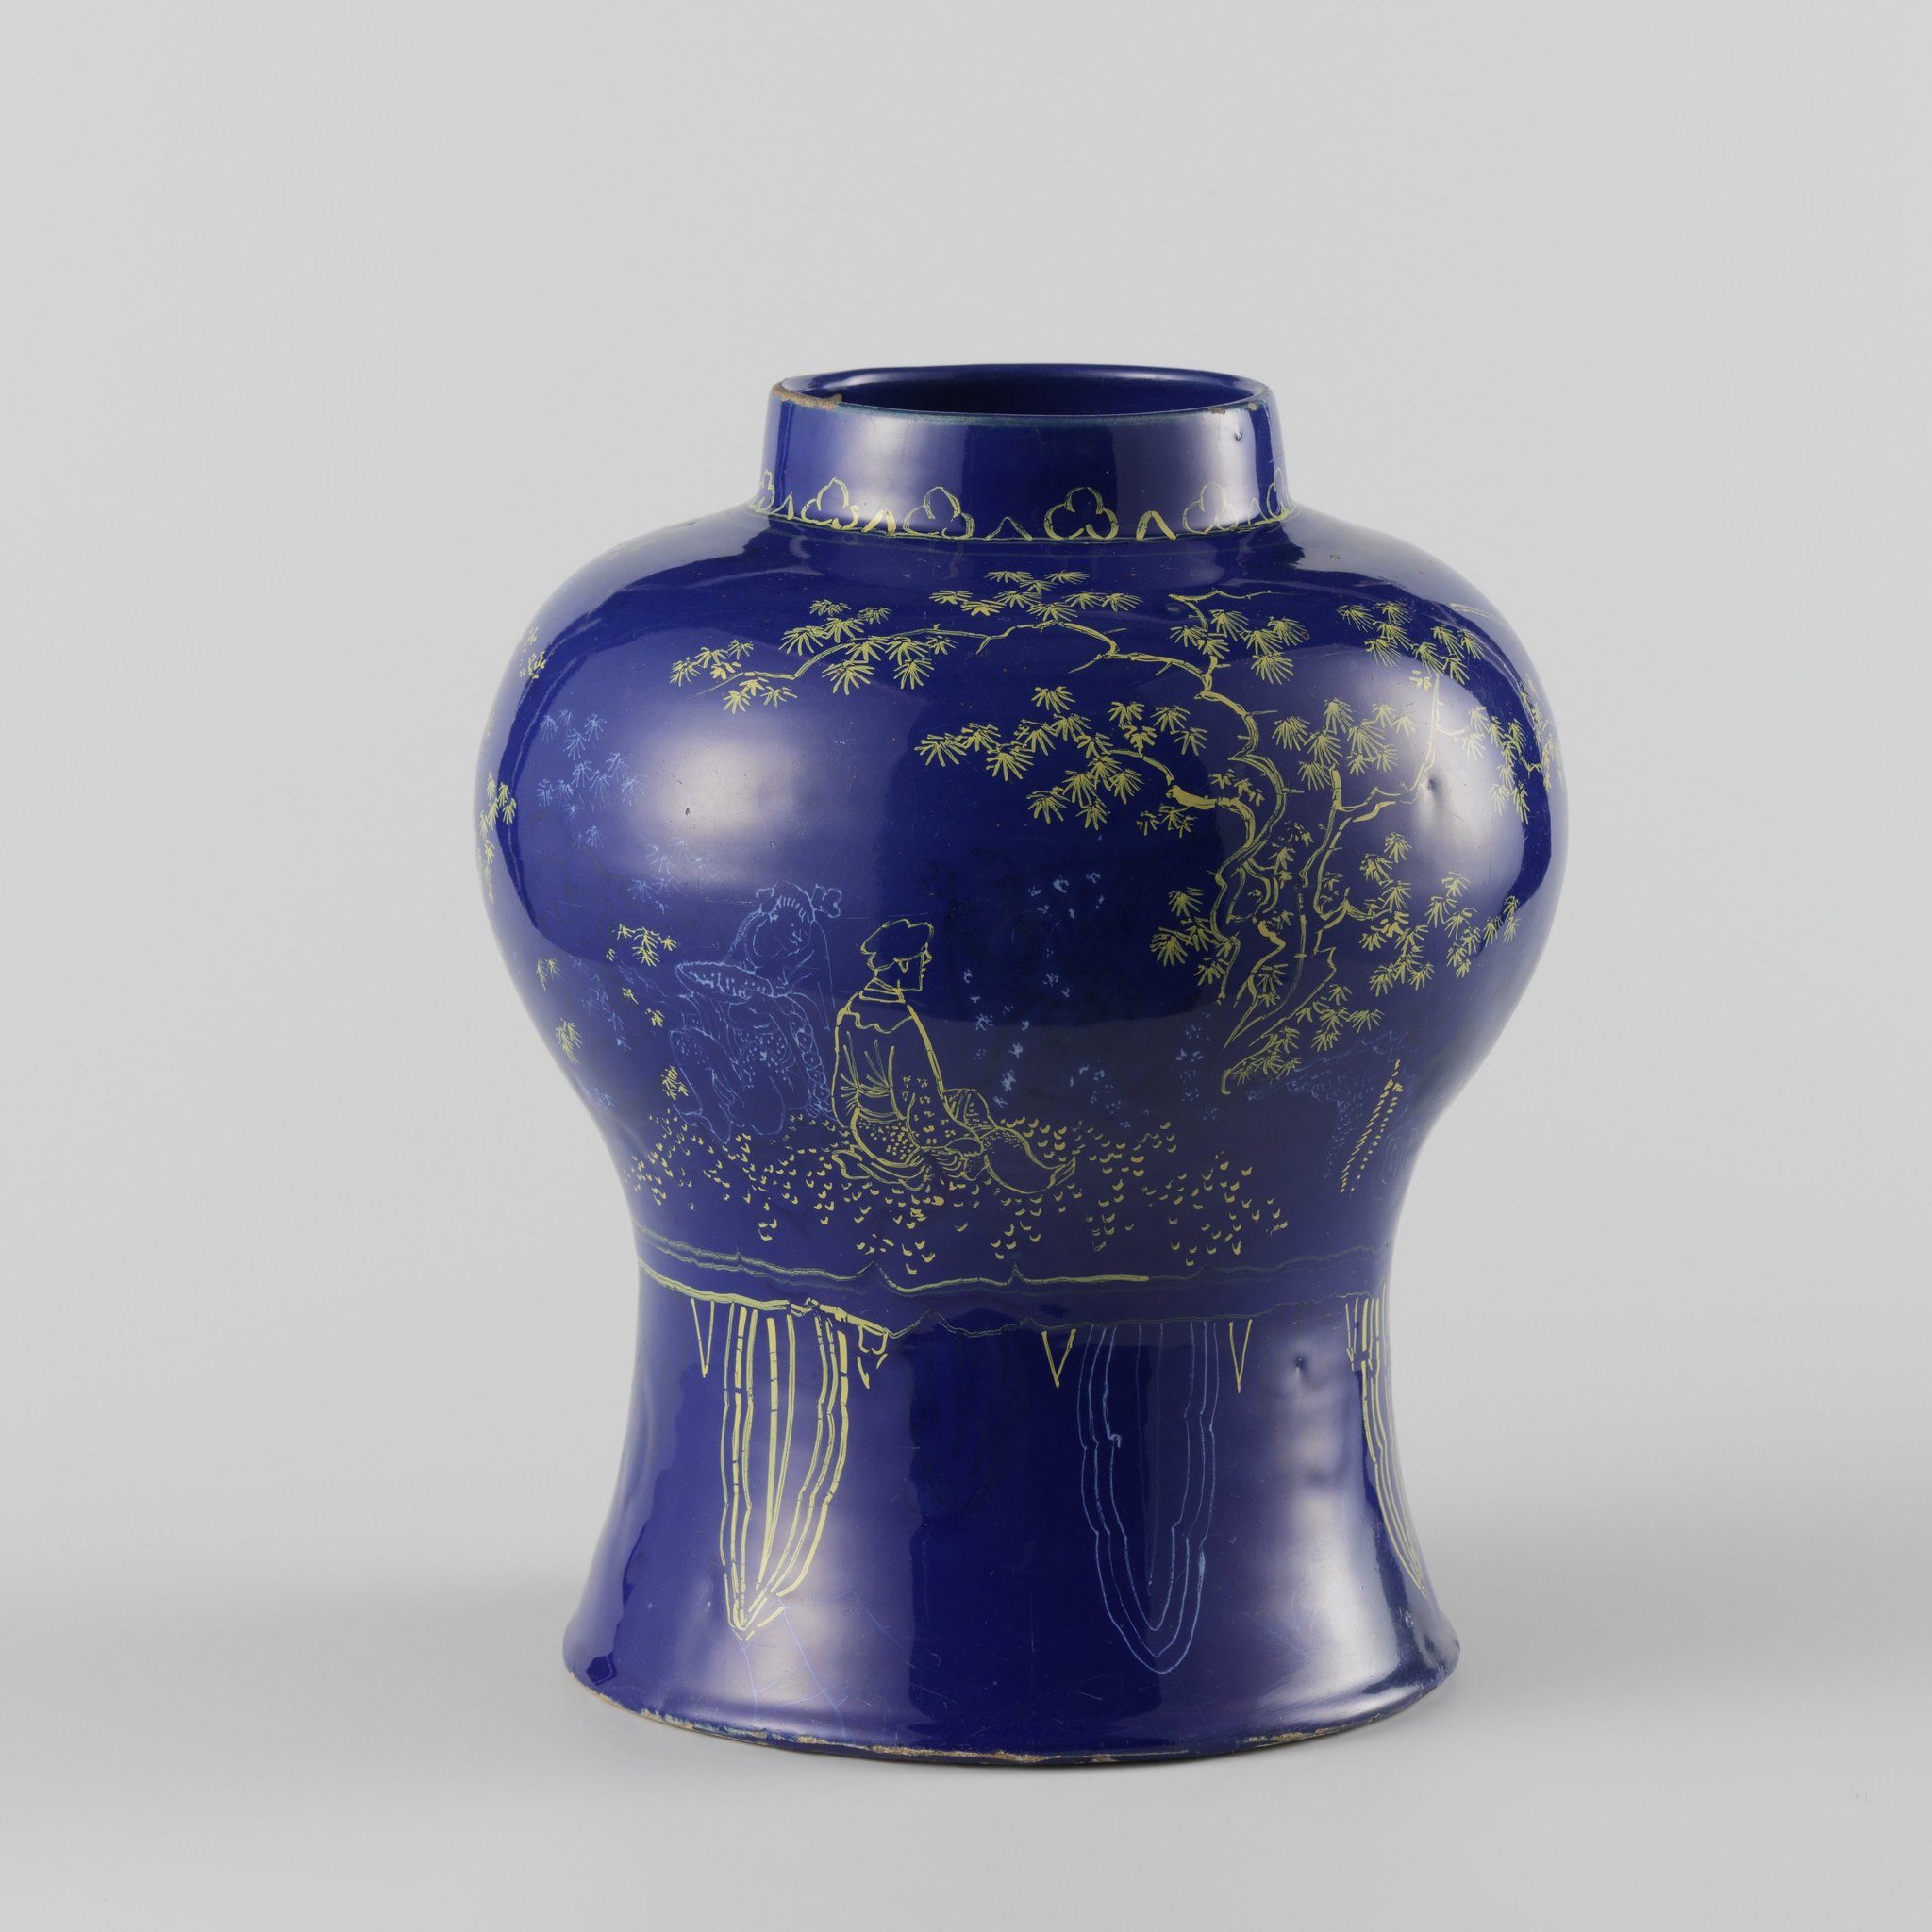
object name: kaststel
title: Pot van faience met blauw fond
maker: Anonymous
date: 1700-1735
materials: faience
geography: delft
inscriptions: label: ‘19’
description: Pot van faience. Veelkleurig beschilderd met chinese figuren en bomen op een blauw fond.